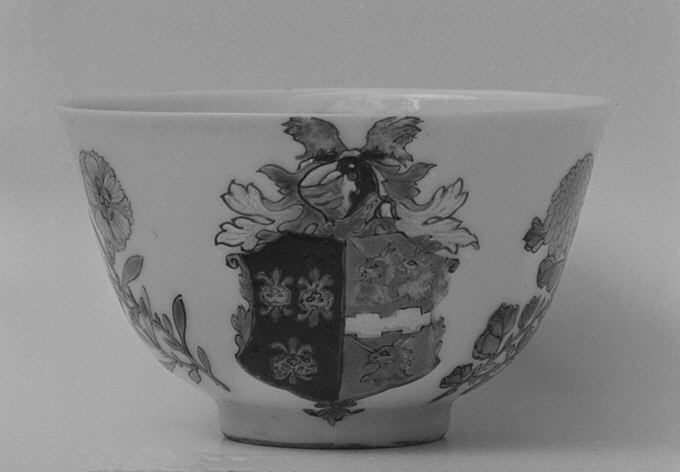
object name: teabowl and saucer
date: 1730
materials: hard paste porcelain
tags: flowers,coat of arms